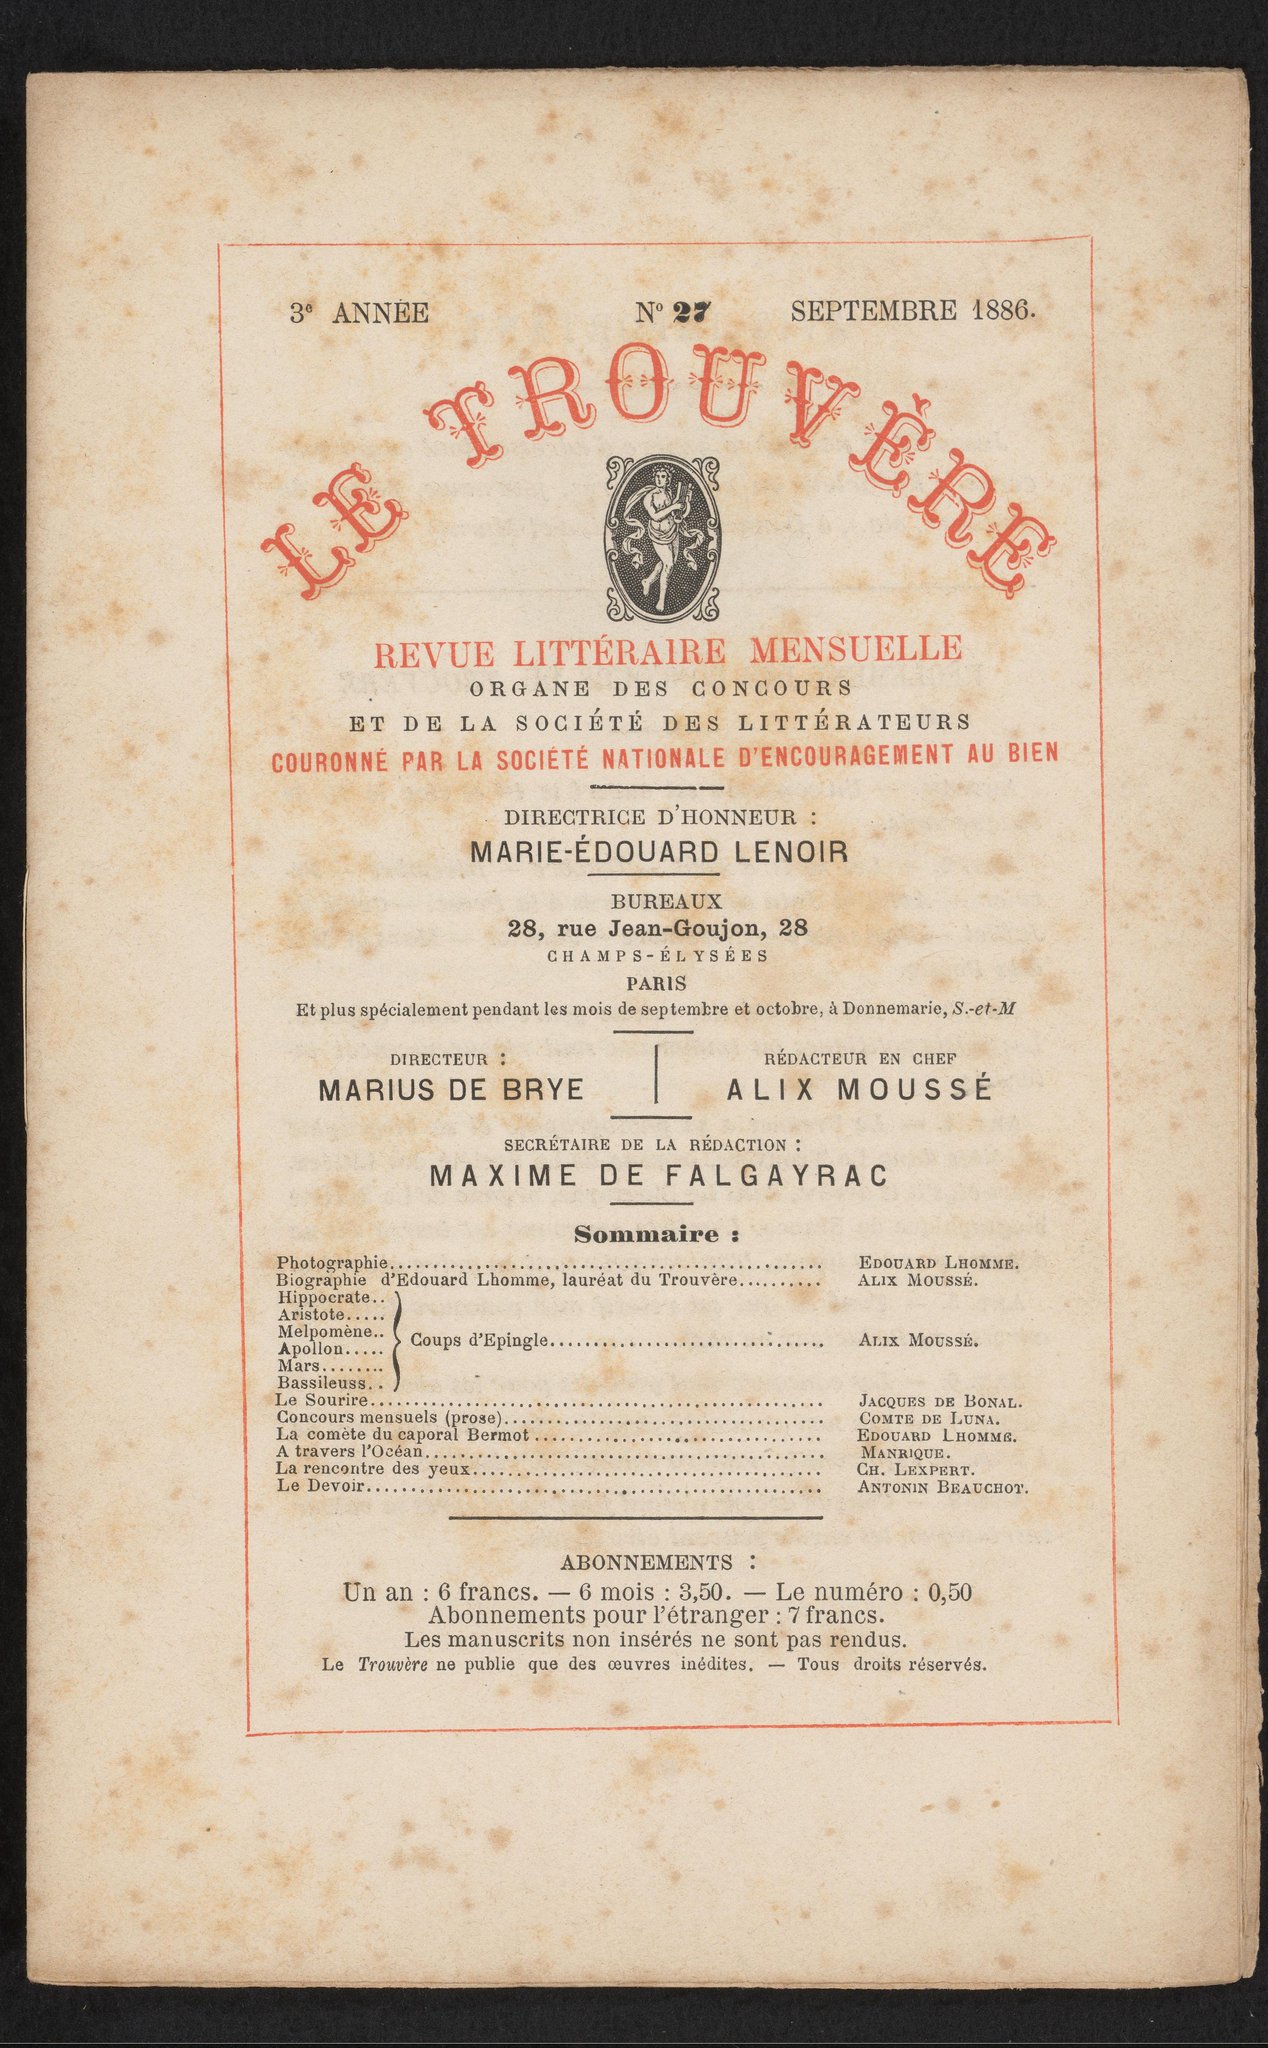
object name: book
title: Le trouvère No 27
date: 1809-1886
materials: paper, photographic support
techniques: albumen print, printing, engraving